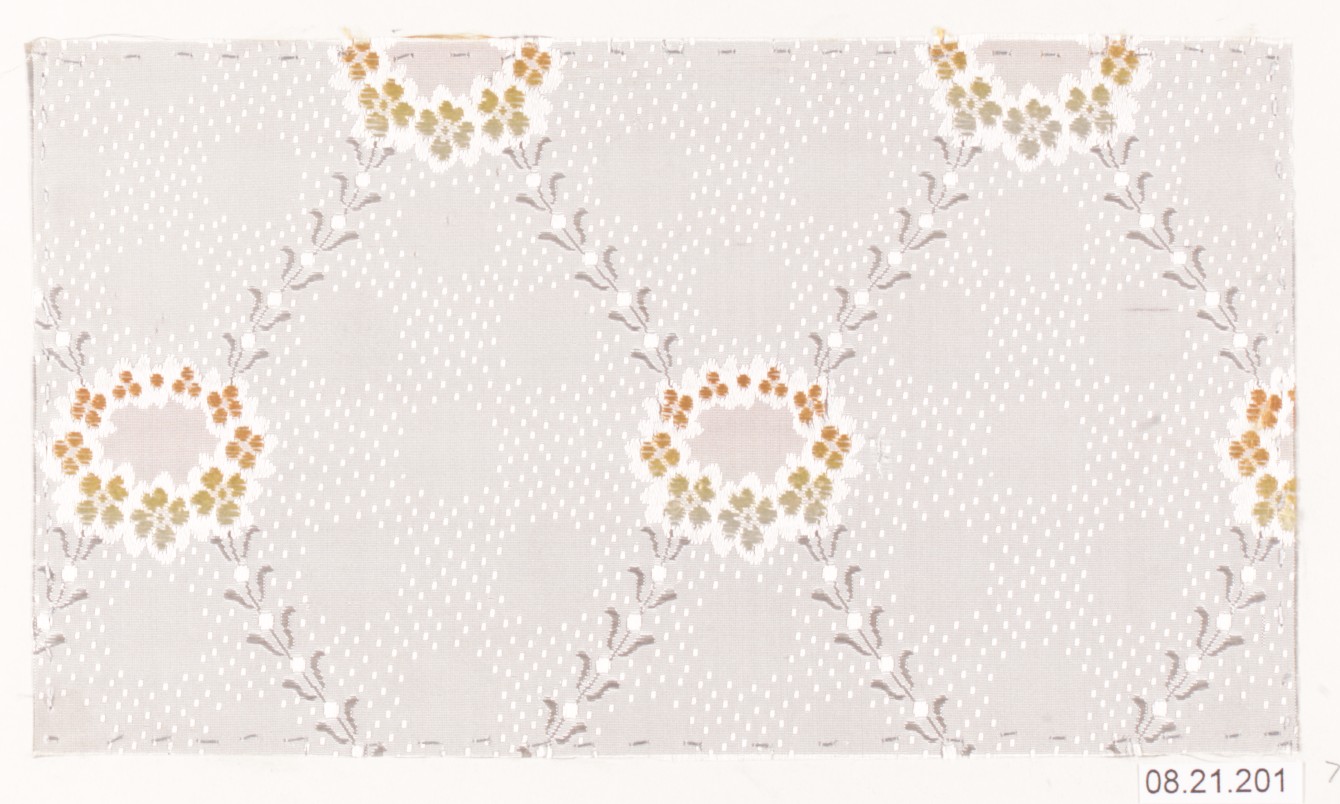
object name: textile sample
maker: Anonymous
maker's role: designer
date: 1900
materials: silk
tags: flowers